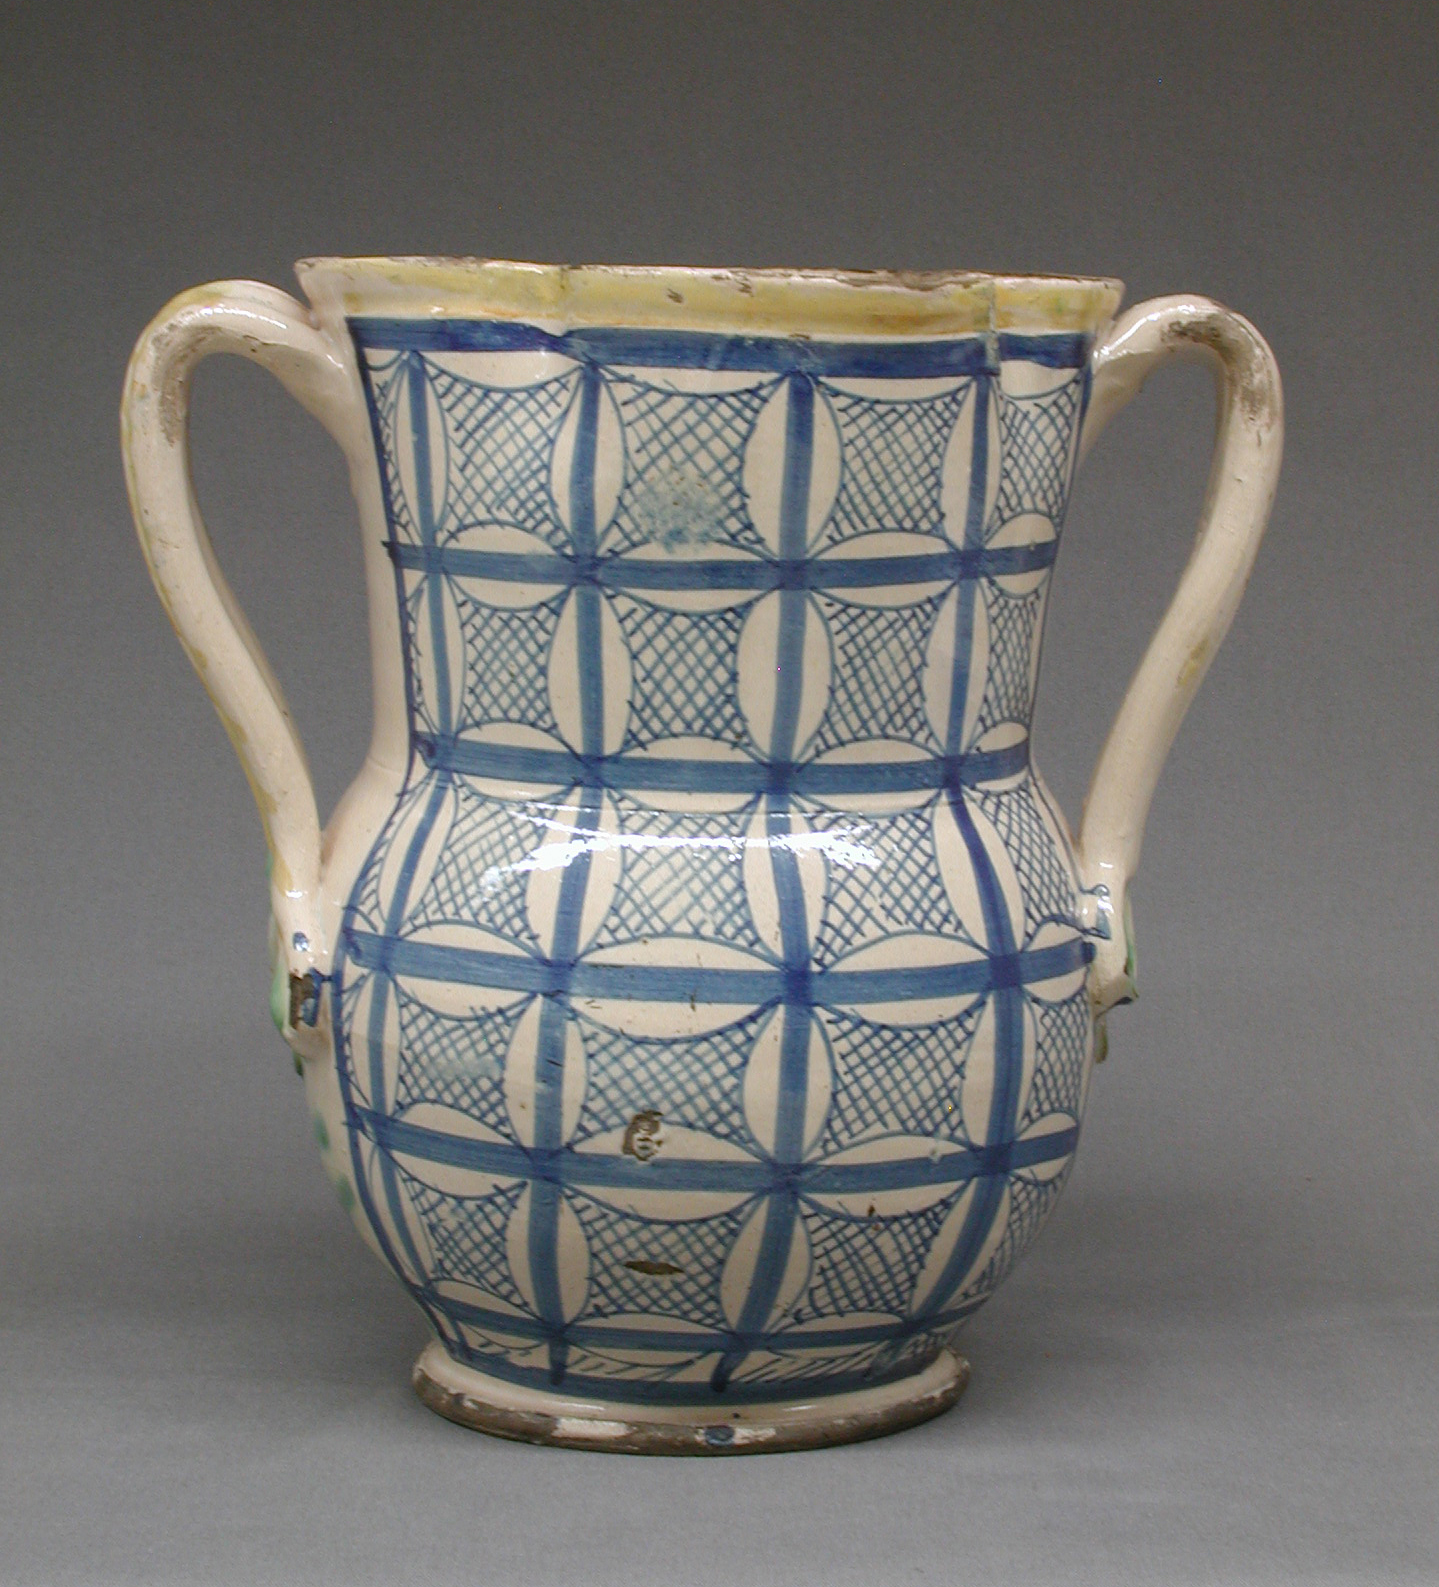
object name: vase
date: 1701-1800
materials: earthenware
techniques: glazing